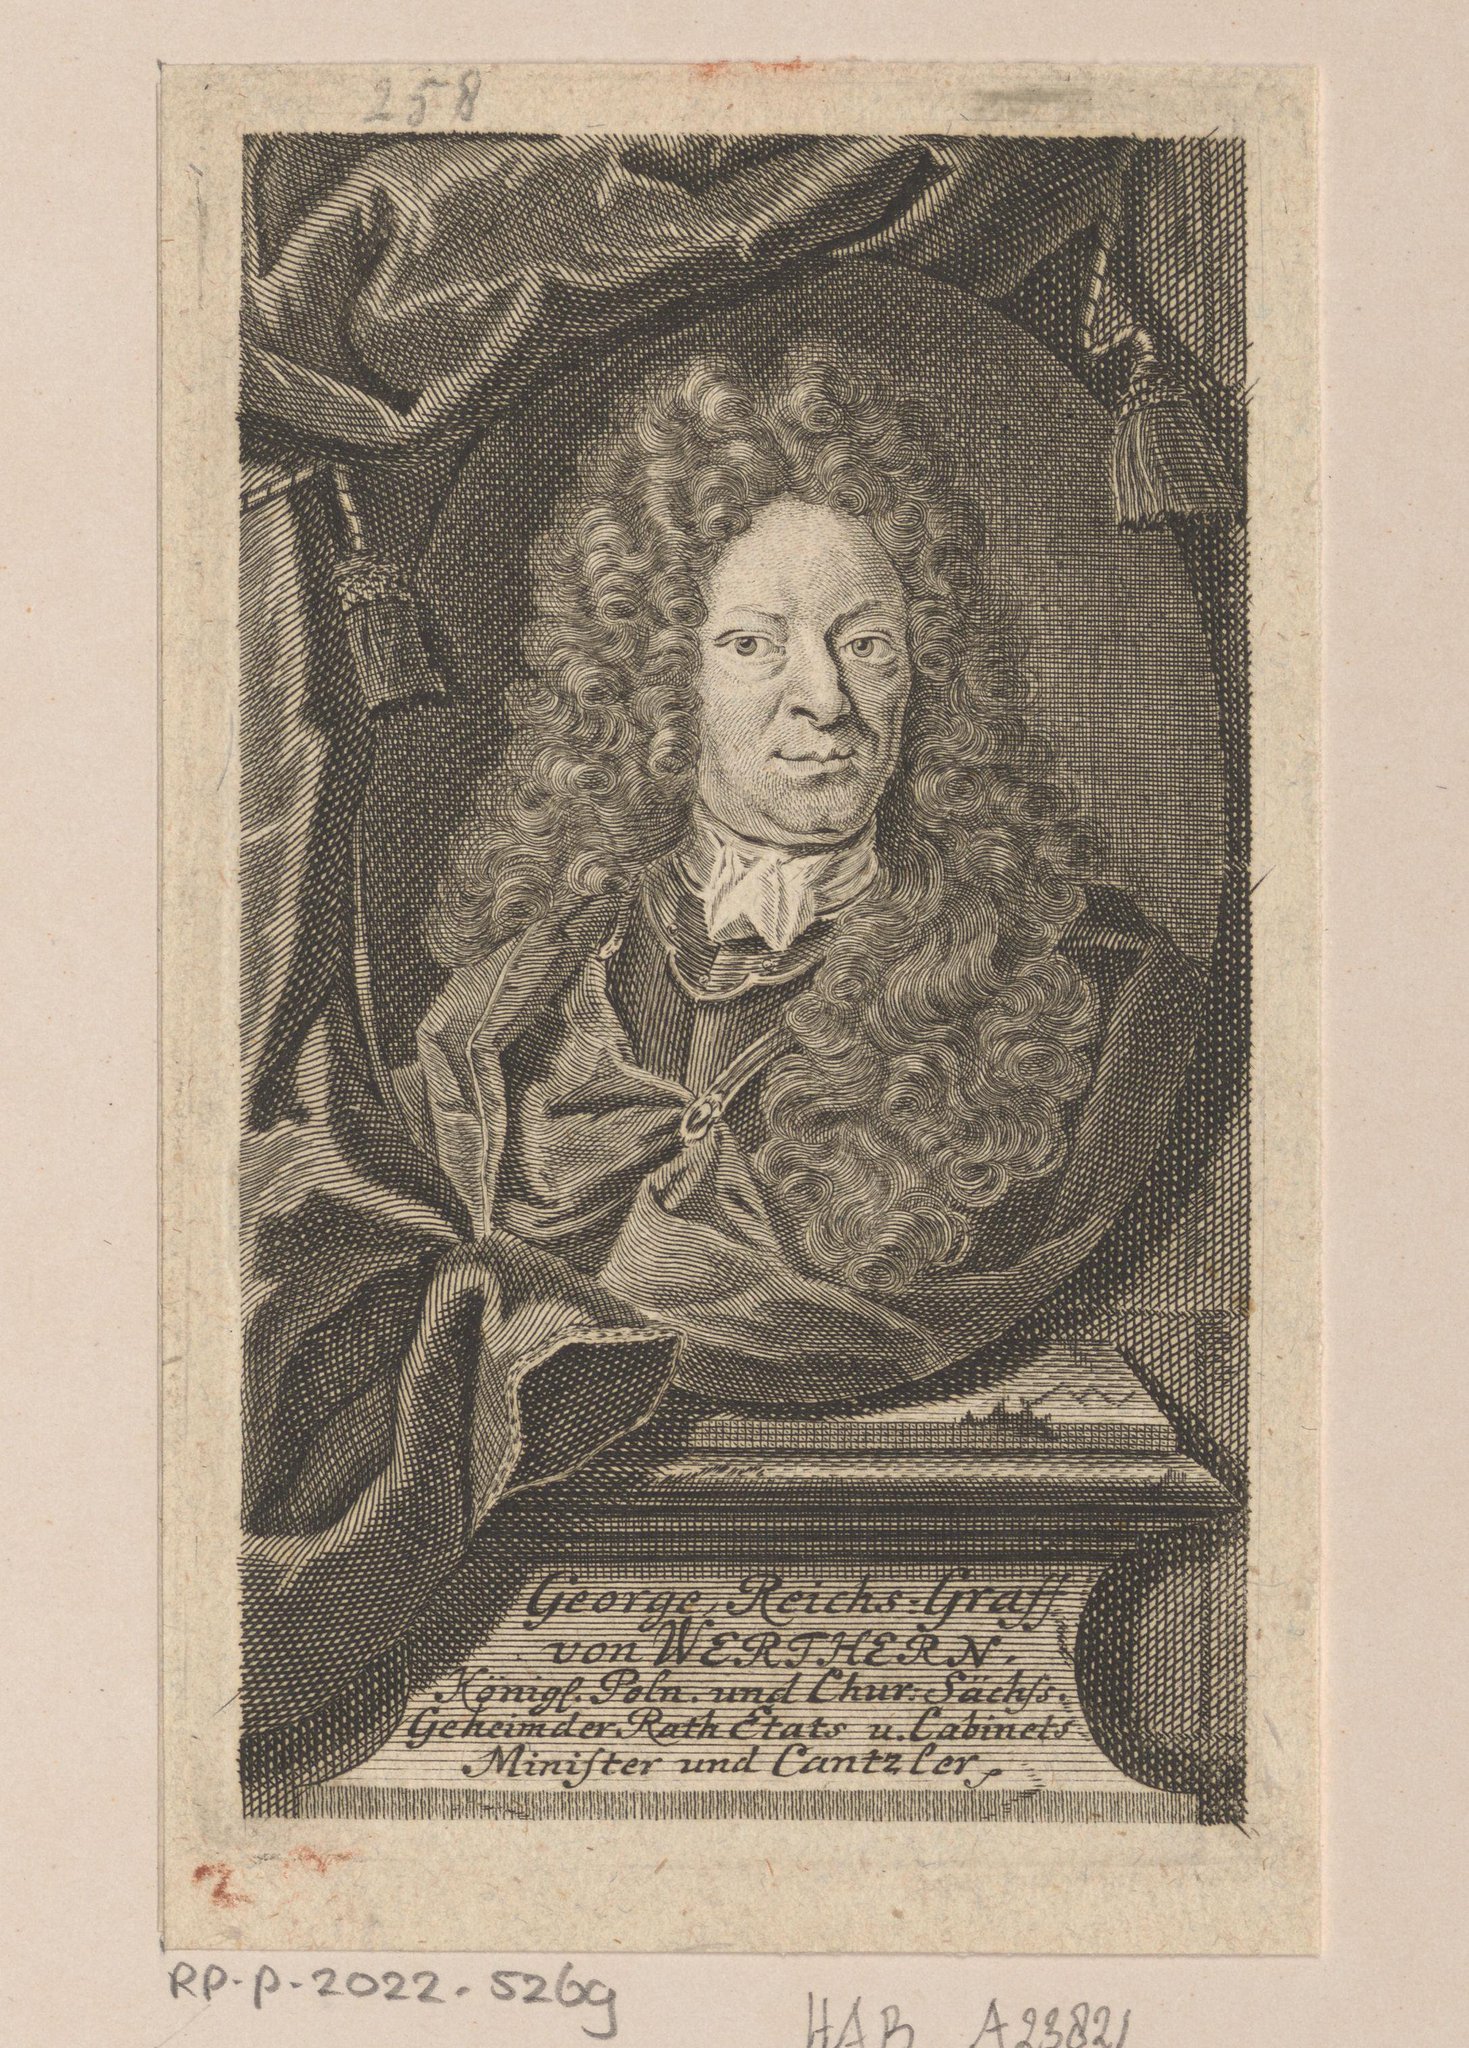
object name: print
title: Portret van Georg, graaf van Werthern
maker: martin bernigeroth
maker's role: print maker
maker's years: 1670-1733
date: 1710-1733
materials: paper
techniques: engraving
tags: historical persons